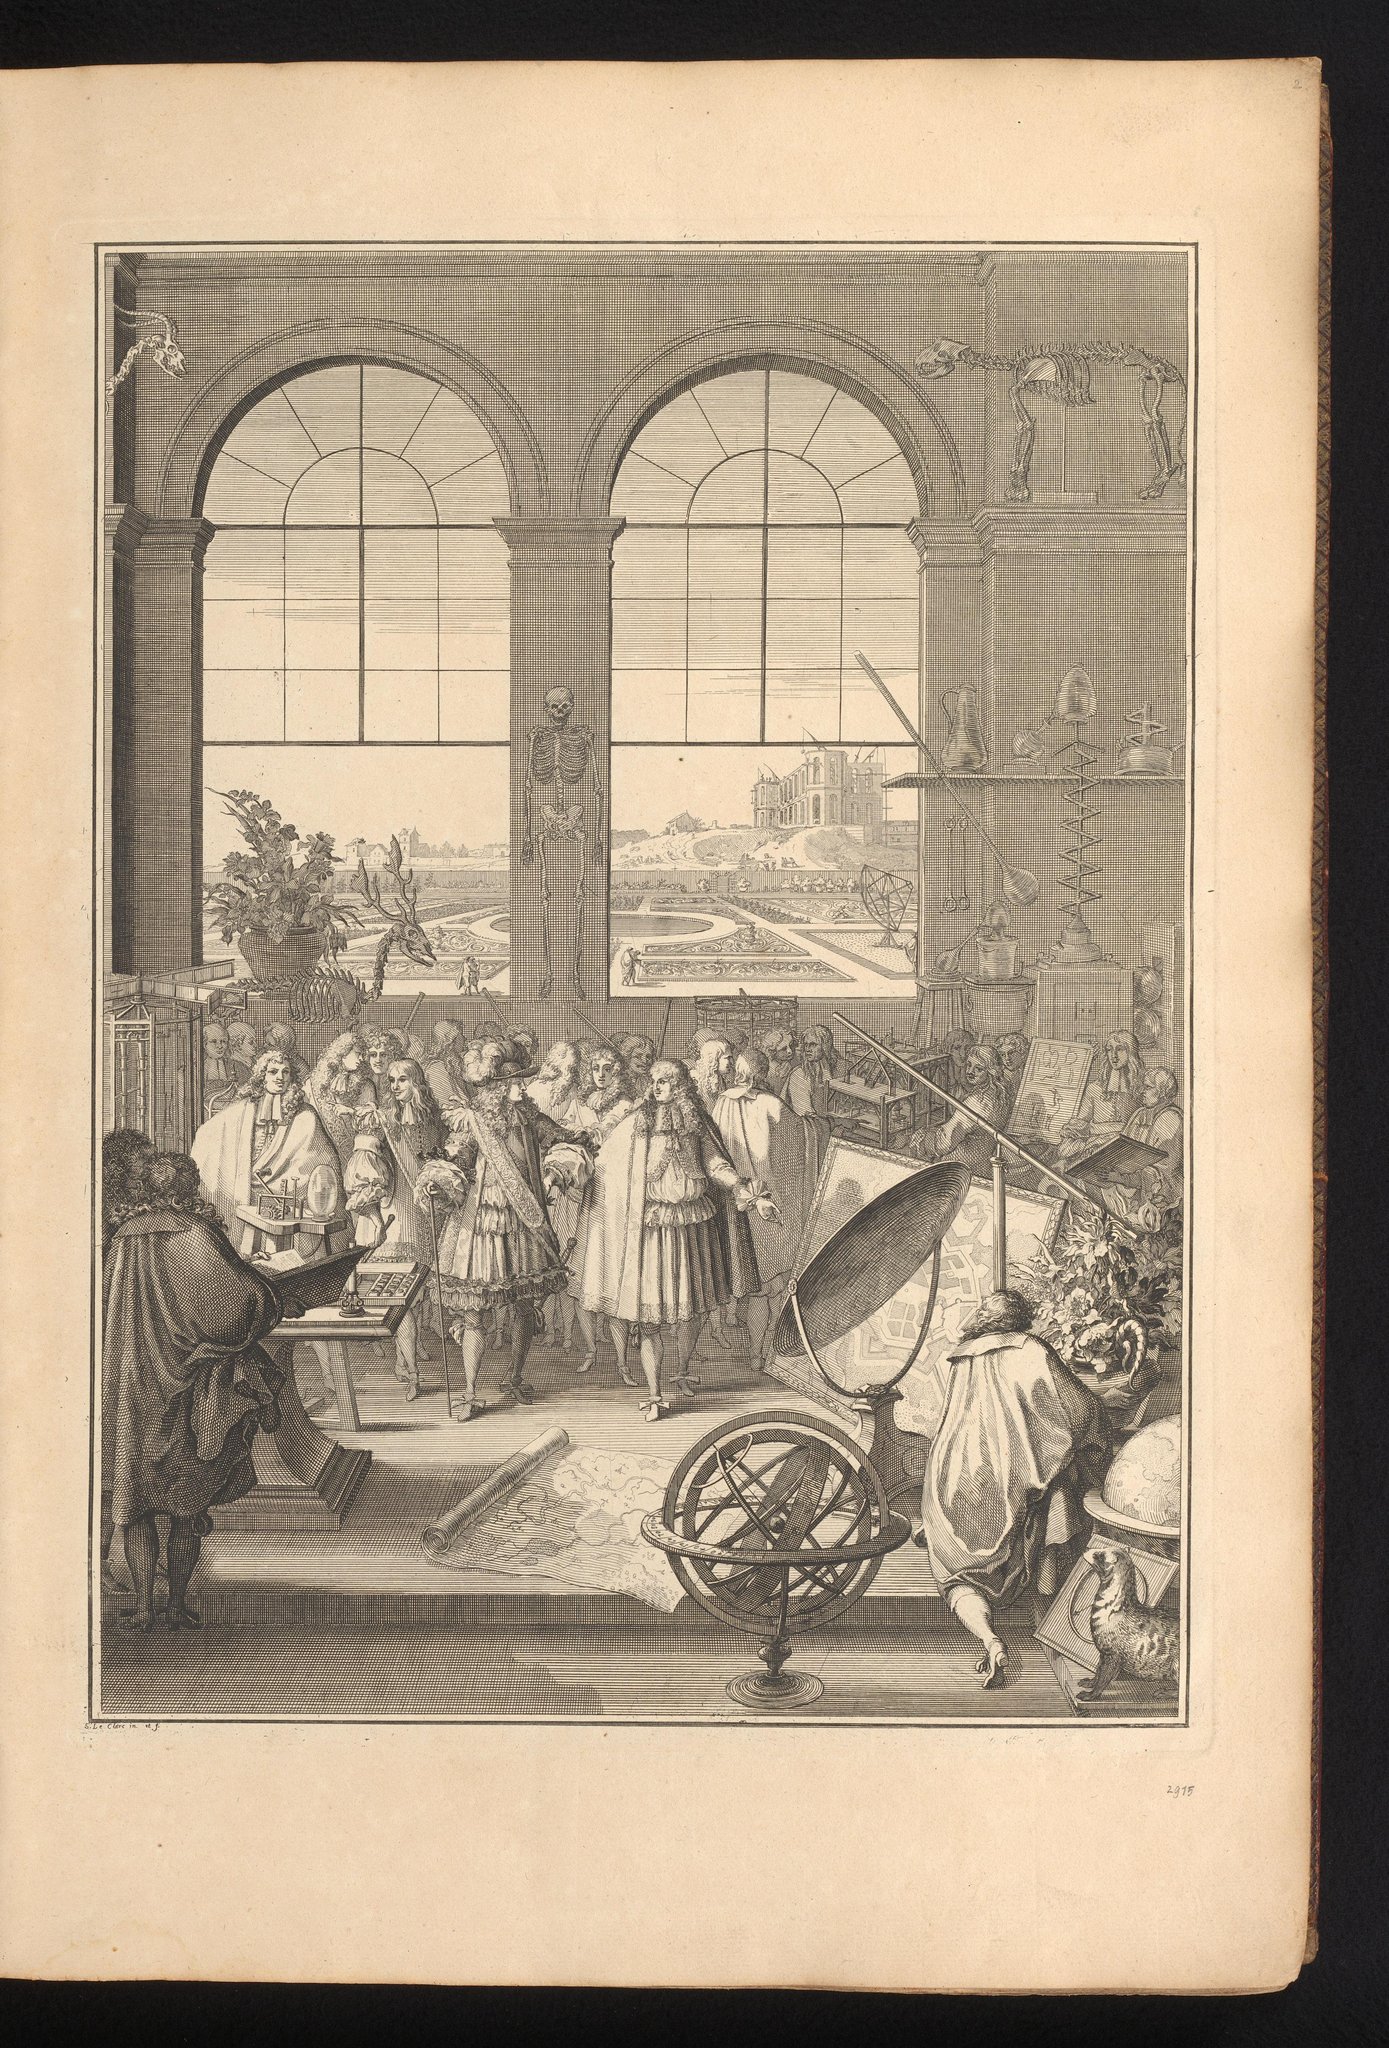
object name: album leaf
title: Titelpagina voor: Claude Perrault, Mémoires pour servir à l'histoire naturelle des animaux, 1671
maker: sébastien leclerc (i)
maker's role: print maker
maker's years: 1637-1714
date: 1671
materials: paper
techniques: engraving, etching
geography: paris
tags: lodewijk xiv (koning van frankrijk), paris, jean-baptiste colbert, group of scholars or philosophers, historical persons, botanic garden, 'hortus botanicus', king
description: Titelpagina voor: Perrault, Claude. Mémoires pour servir à l'histoire naturelle des animaux. Parijs: Imprimerie Royale, 1671.